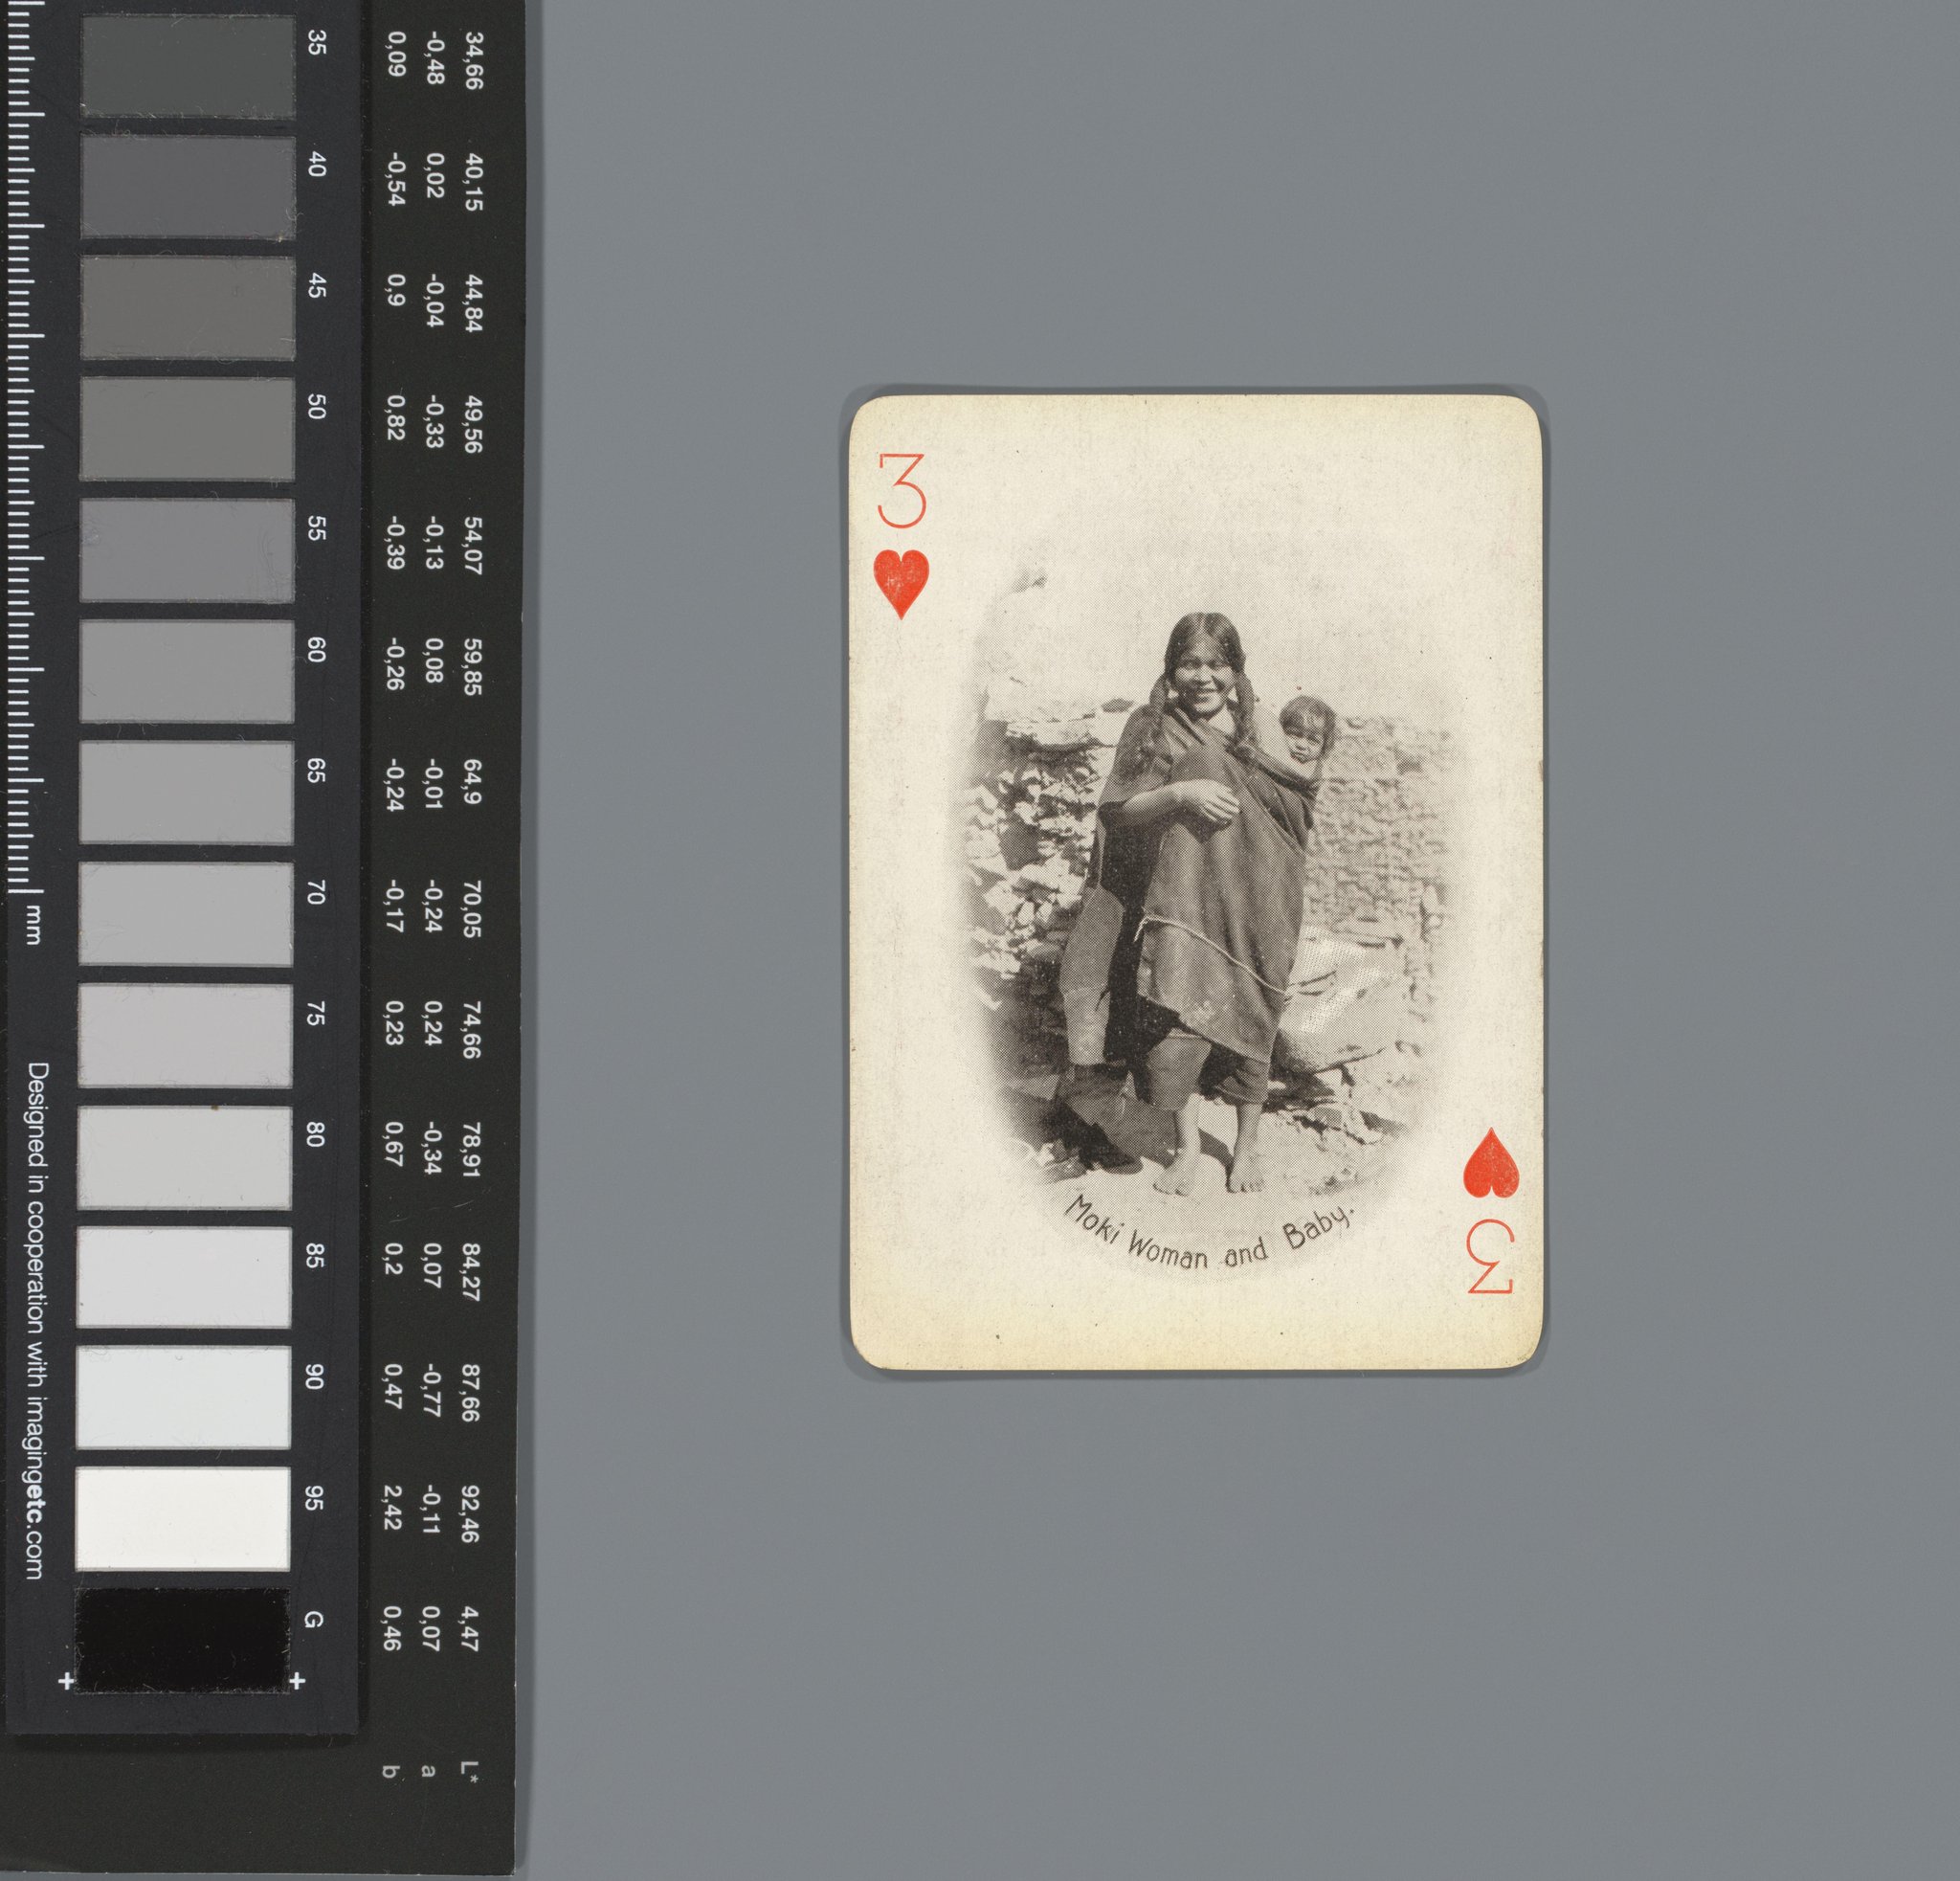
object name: playing card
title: Harten drie met Mokivrouw met baby, Arizona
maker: adam clark vroman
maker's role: fotograaf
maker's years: 1856-1916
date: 1900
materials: paper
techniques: autotype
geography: united states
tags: arizona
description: Speelkaart uit doosje met 53 speelkaarten met afbeeldingen in autotypie van Native Americans. De inhoud bevat een complete set speelkaarten inclusief joker.